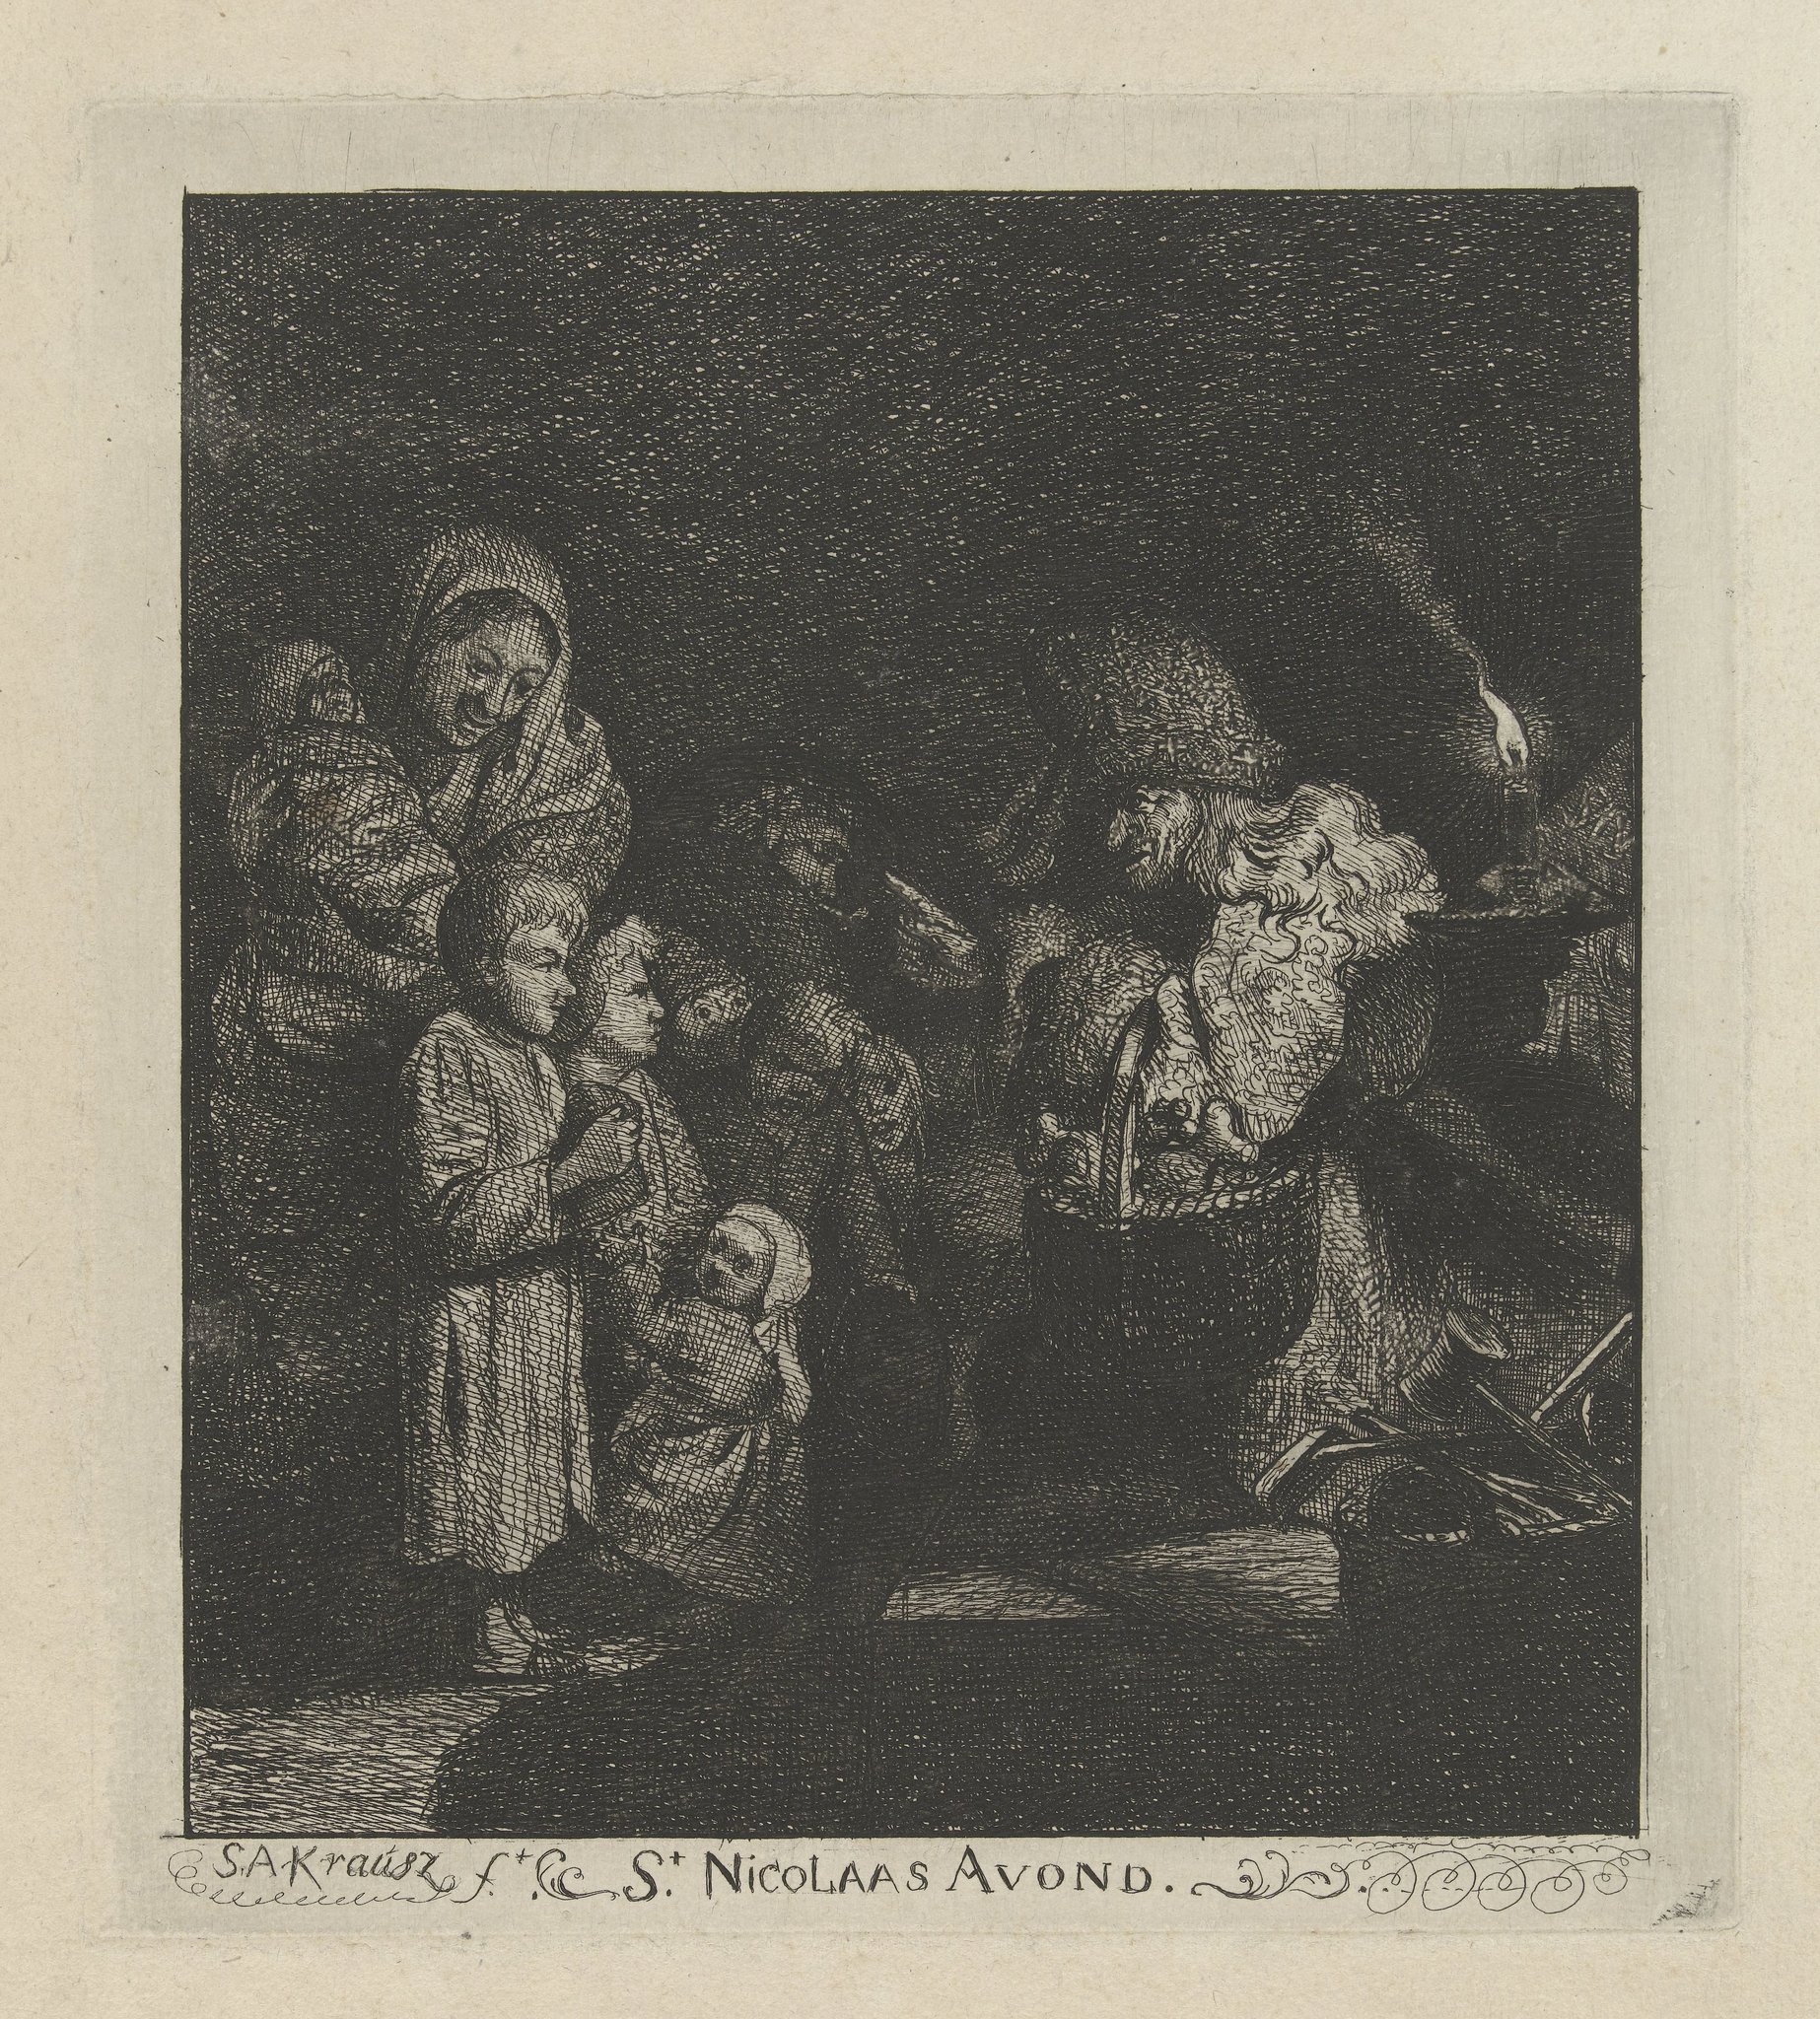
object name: print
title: St Nicolaas Avond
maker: simon andreas krausz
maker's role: draughtsman, print maker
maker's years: 1760-1825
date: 1770-1825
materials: paper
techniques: etching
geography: the hague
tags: head-gear: cap (+ men's clothes), festivities on st. nicholas (eve) (december 5)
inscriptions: collector's mark: Lugt 2228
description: Voor Sint Nicolaas - getooid met een muts en een mand met spullen aan de arm - heeft zich een groep kinderen verzameld. Achter de kinderen staan een man en een vrouw met een baby. Sint Nicolaas spreekt tot de kinderen terwijl hij wordt bijgelicht door een walmende kaars.